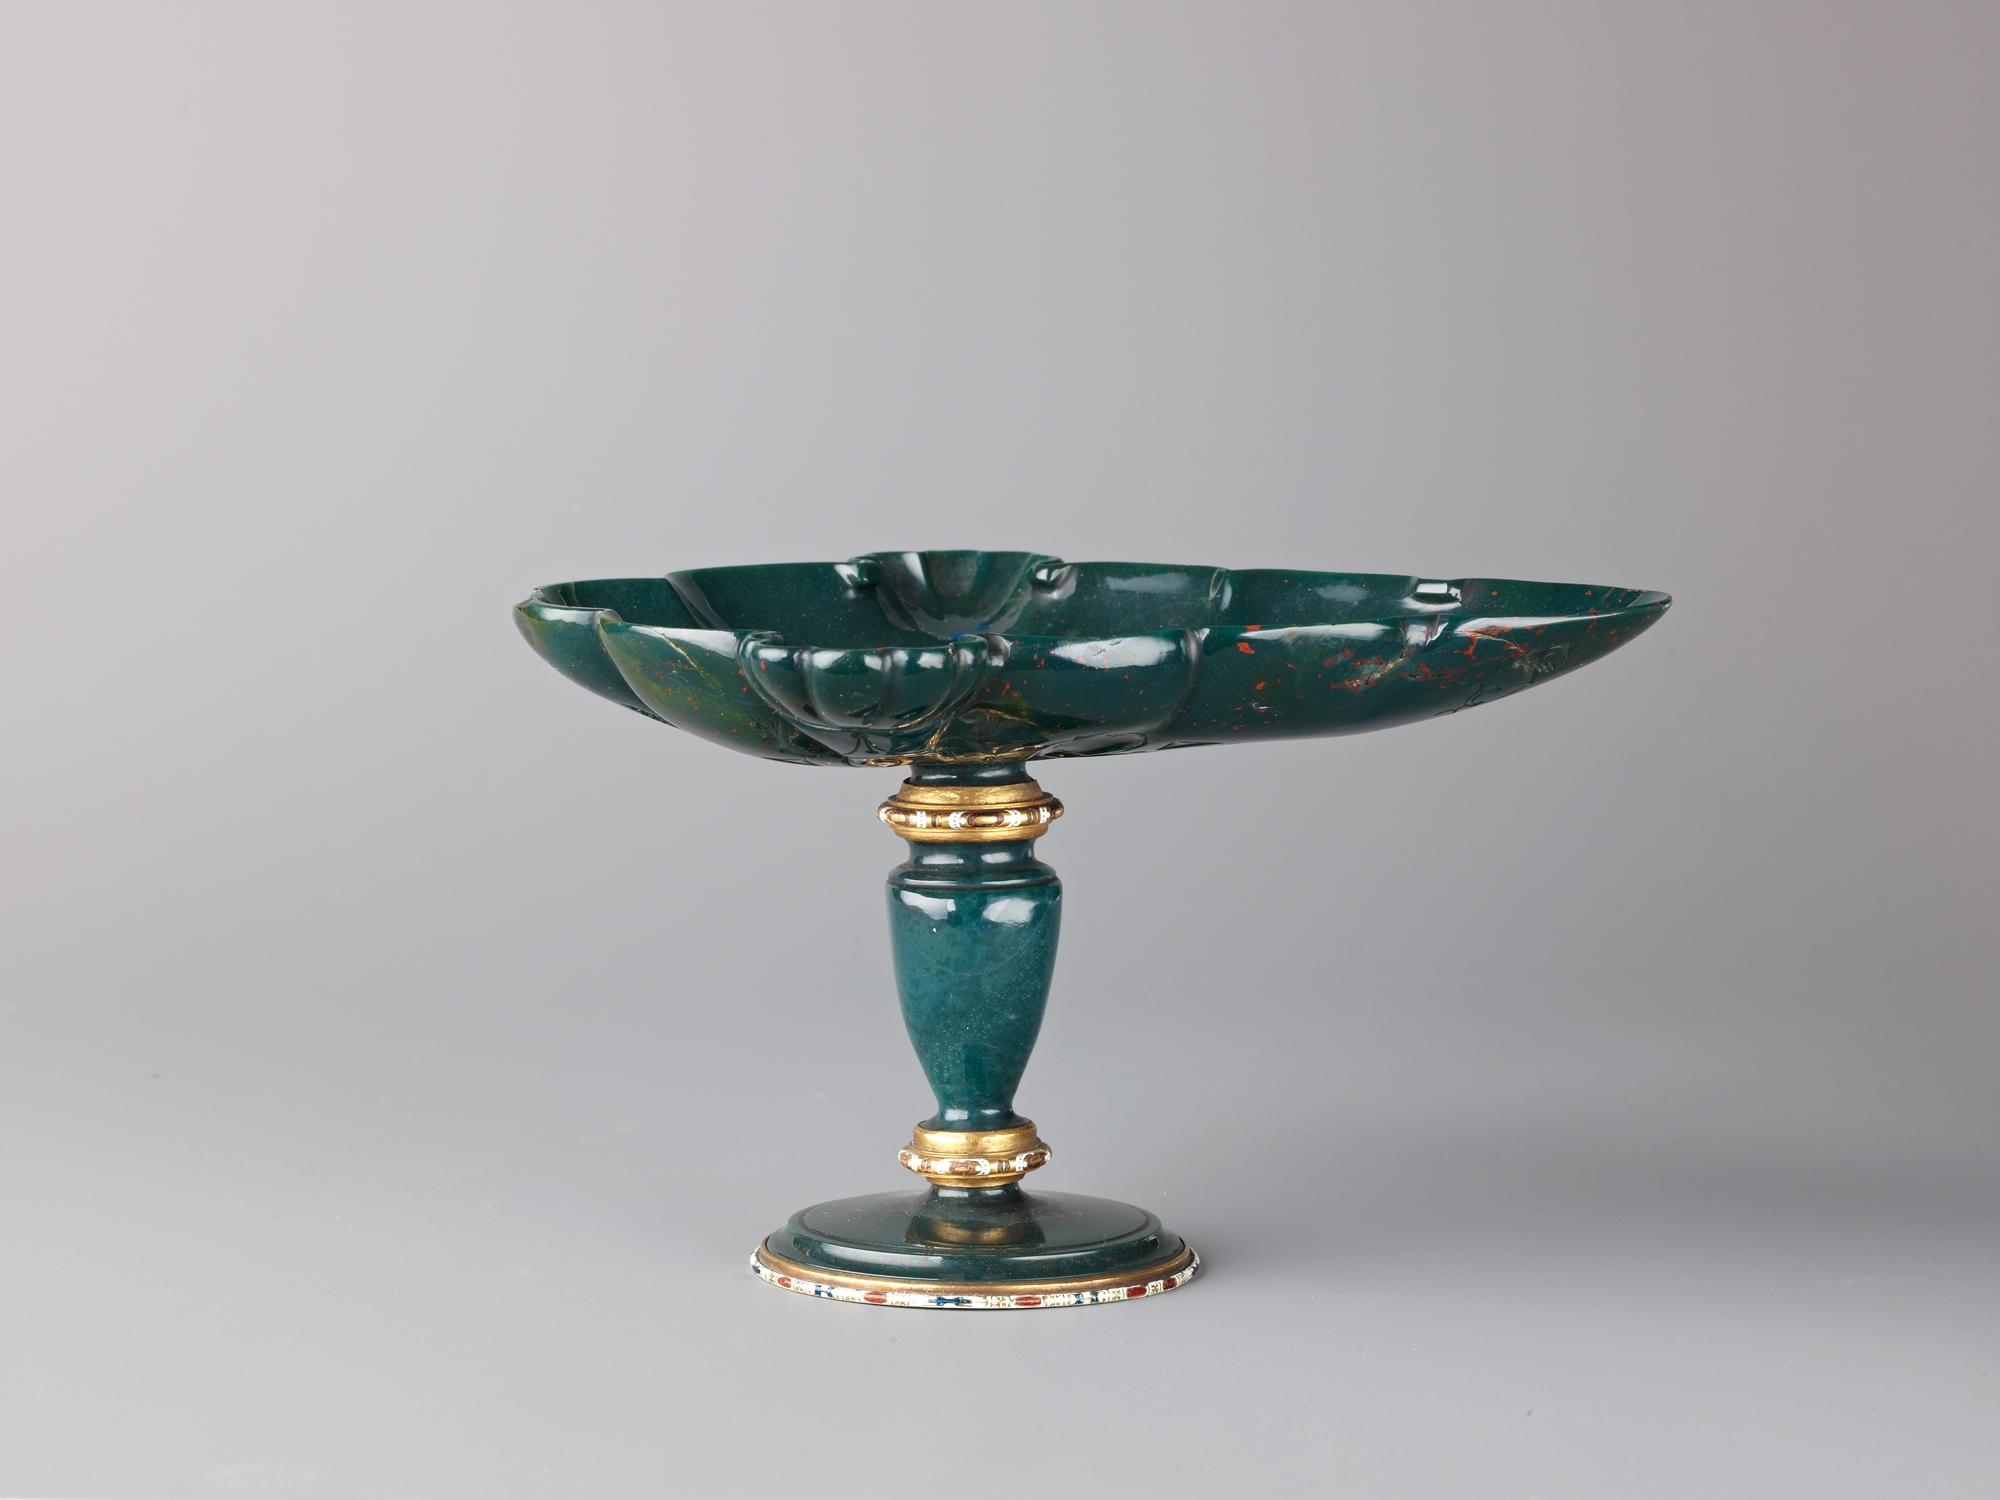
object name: cup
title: Tazza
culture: italian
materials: enamel, gold